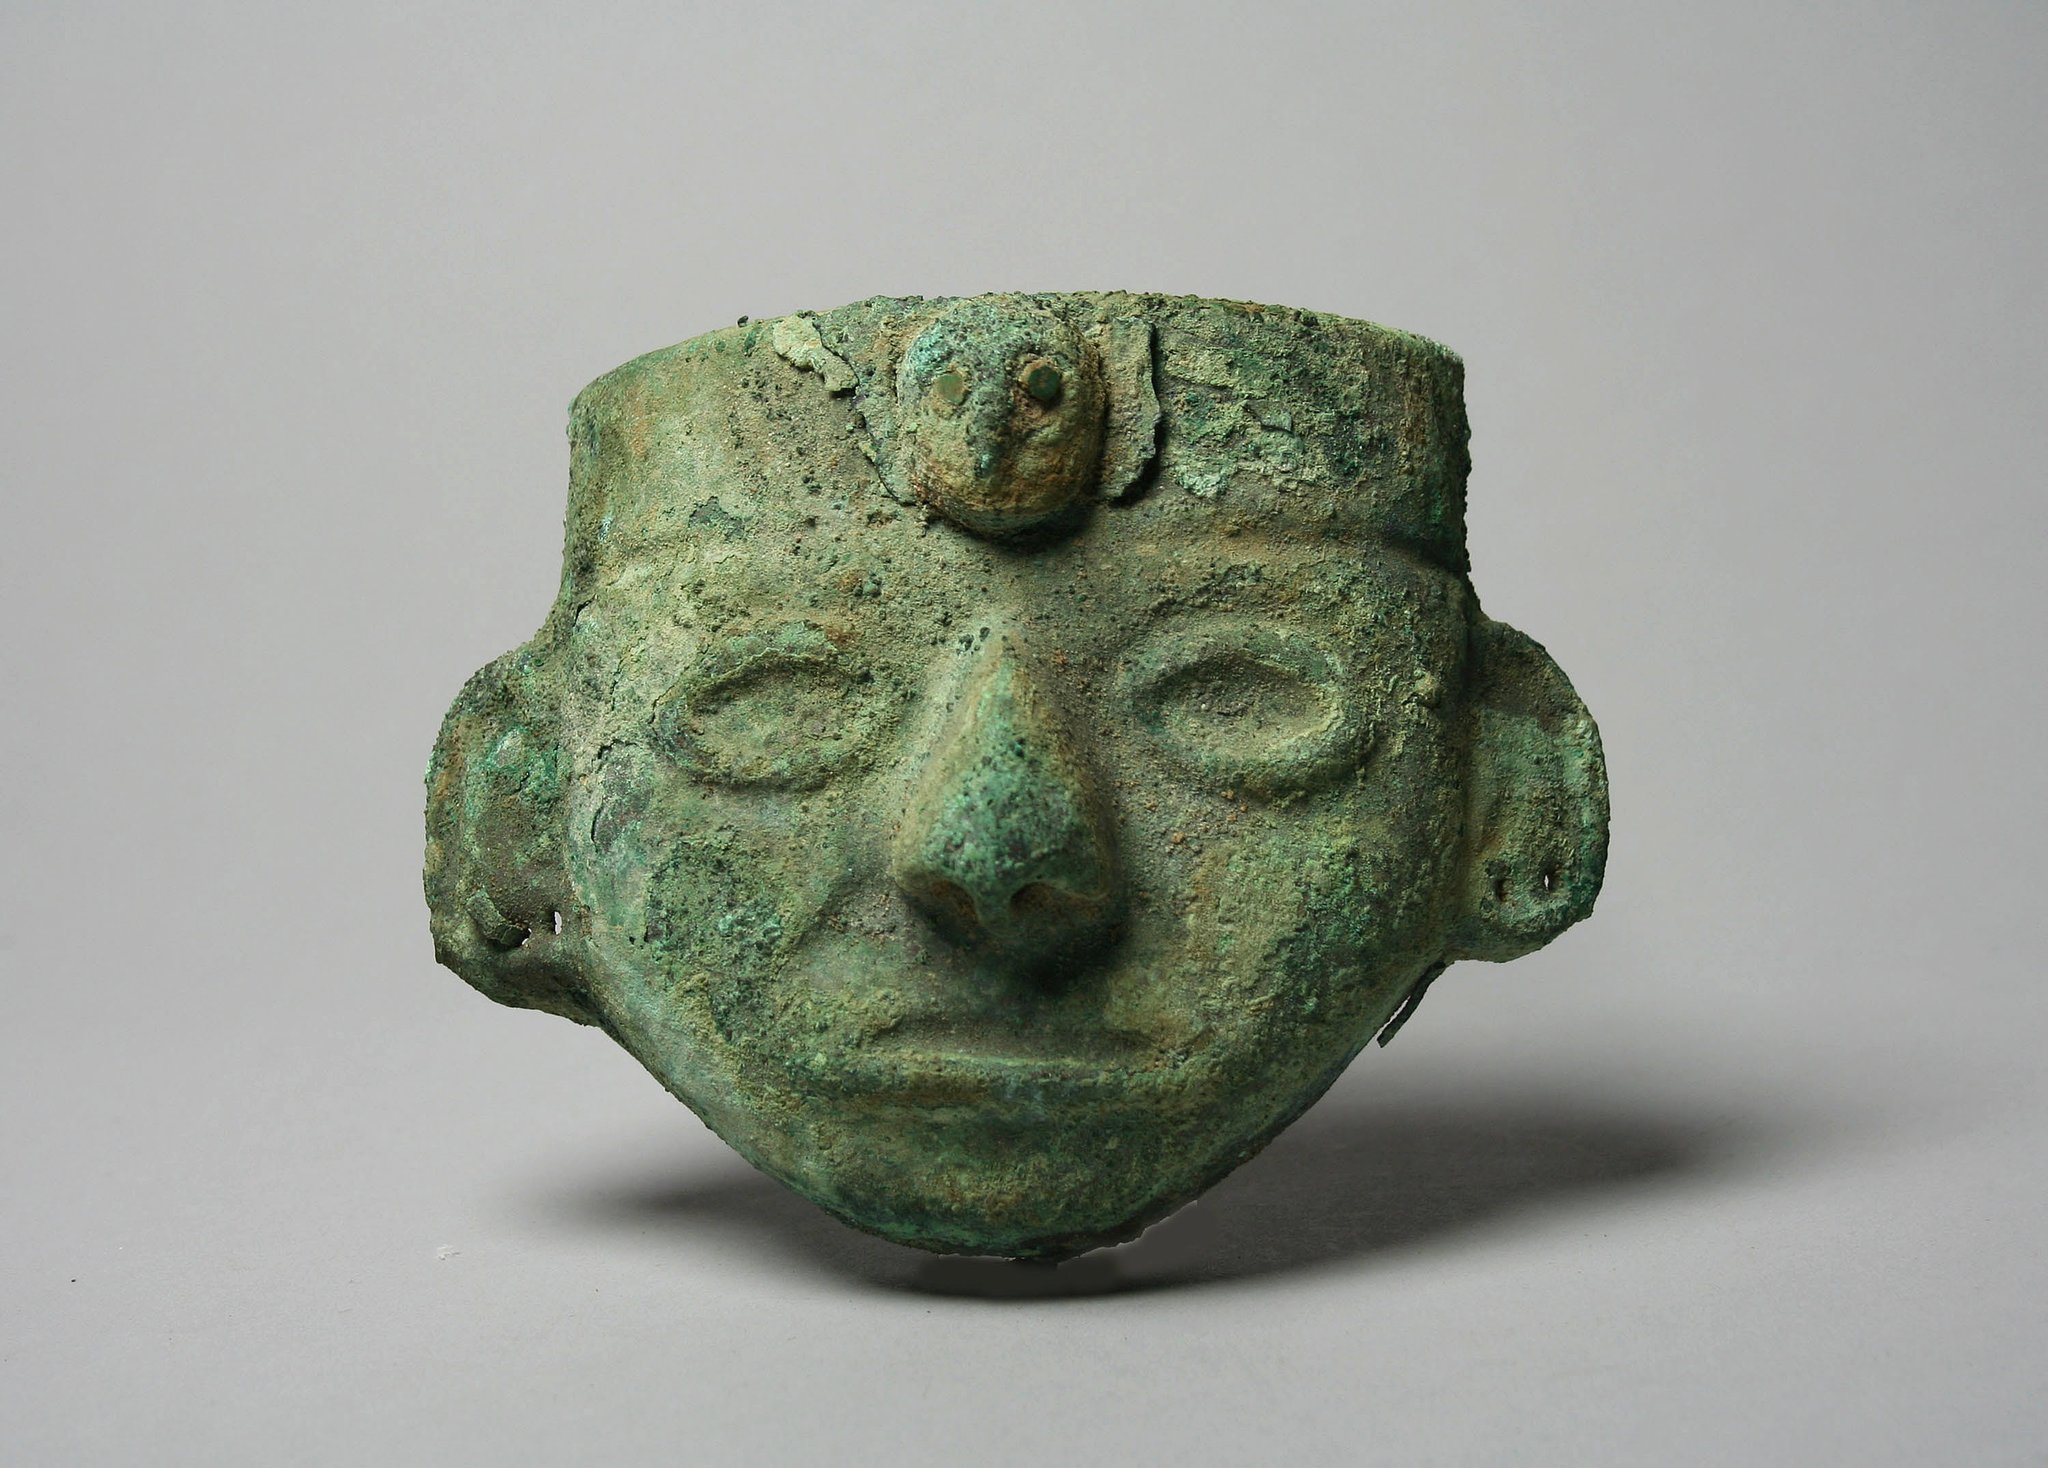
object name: ornament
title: Face Mask Ornament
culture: moche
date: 501-700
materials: gilt copper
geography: peru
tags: faces